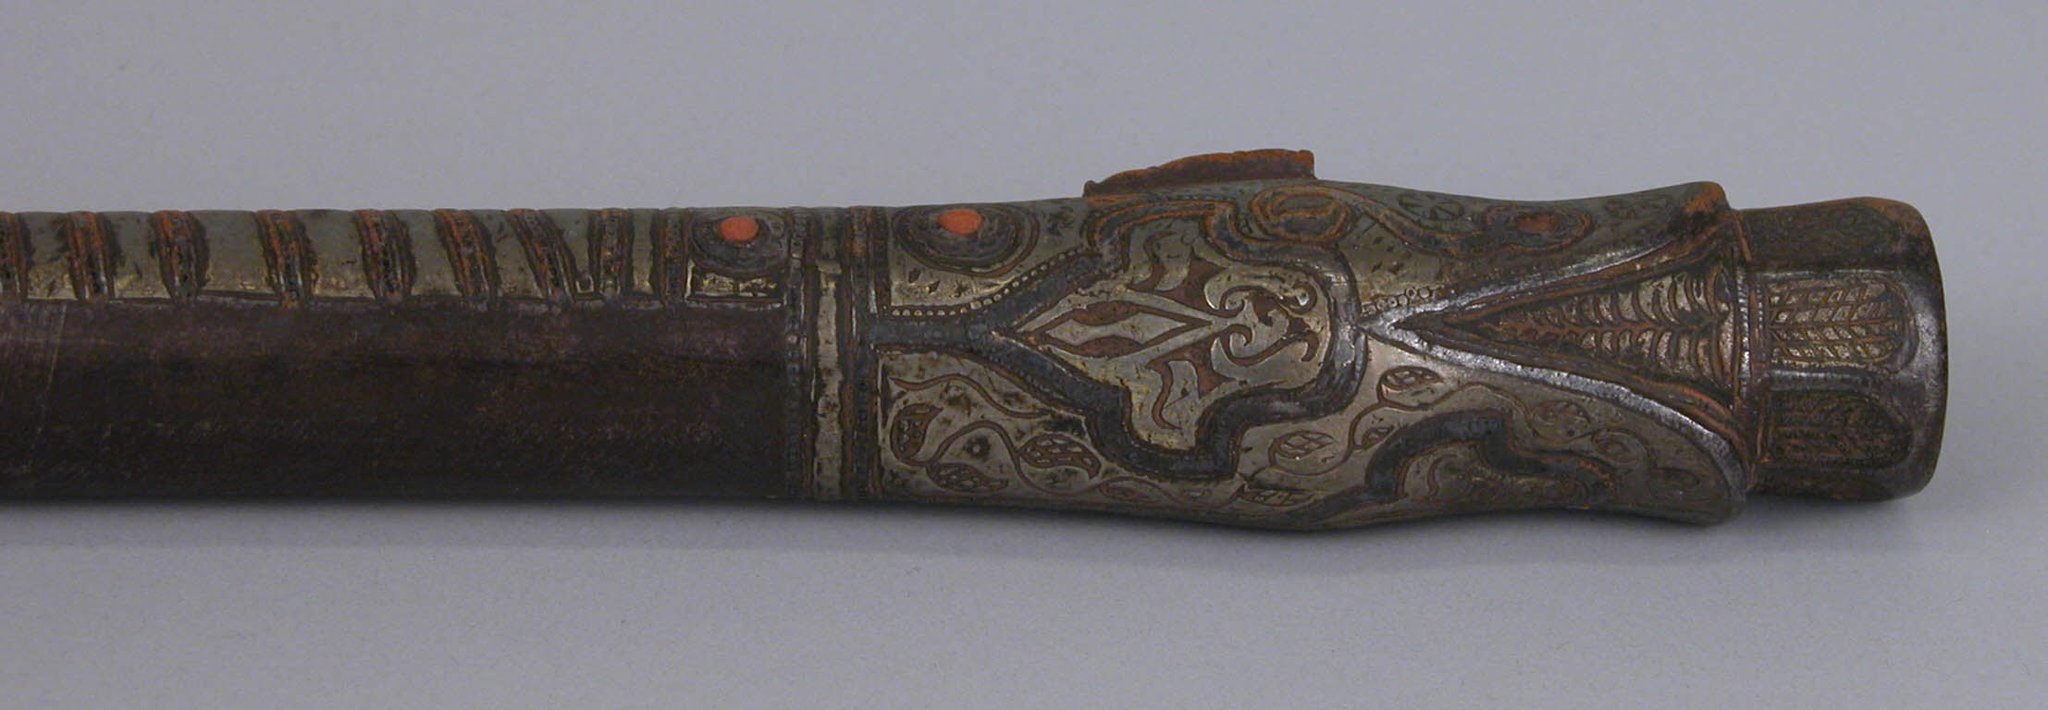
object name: barrel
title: Gun Barrel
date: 1701-1900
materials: copper, coral, silver, steel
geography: india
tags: weapons